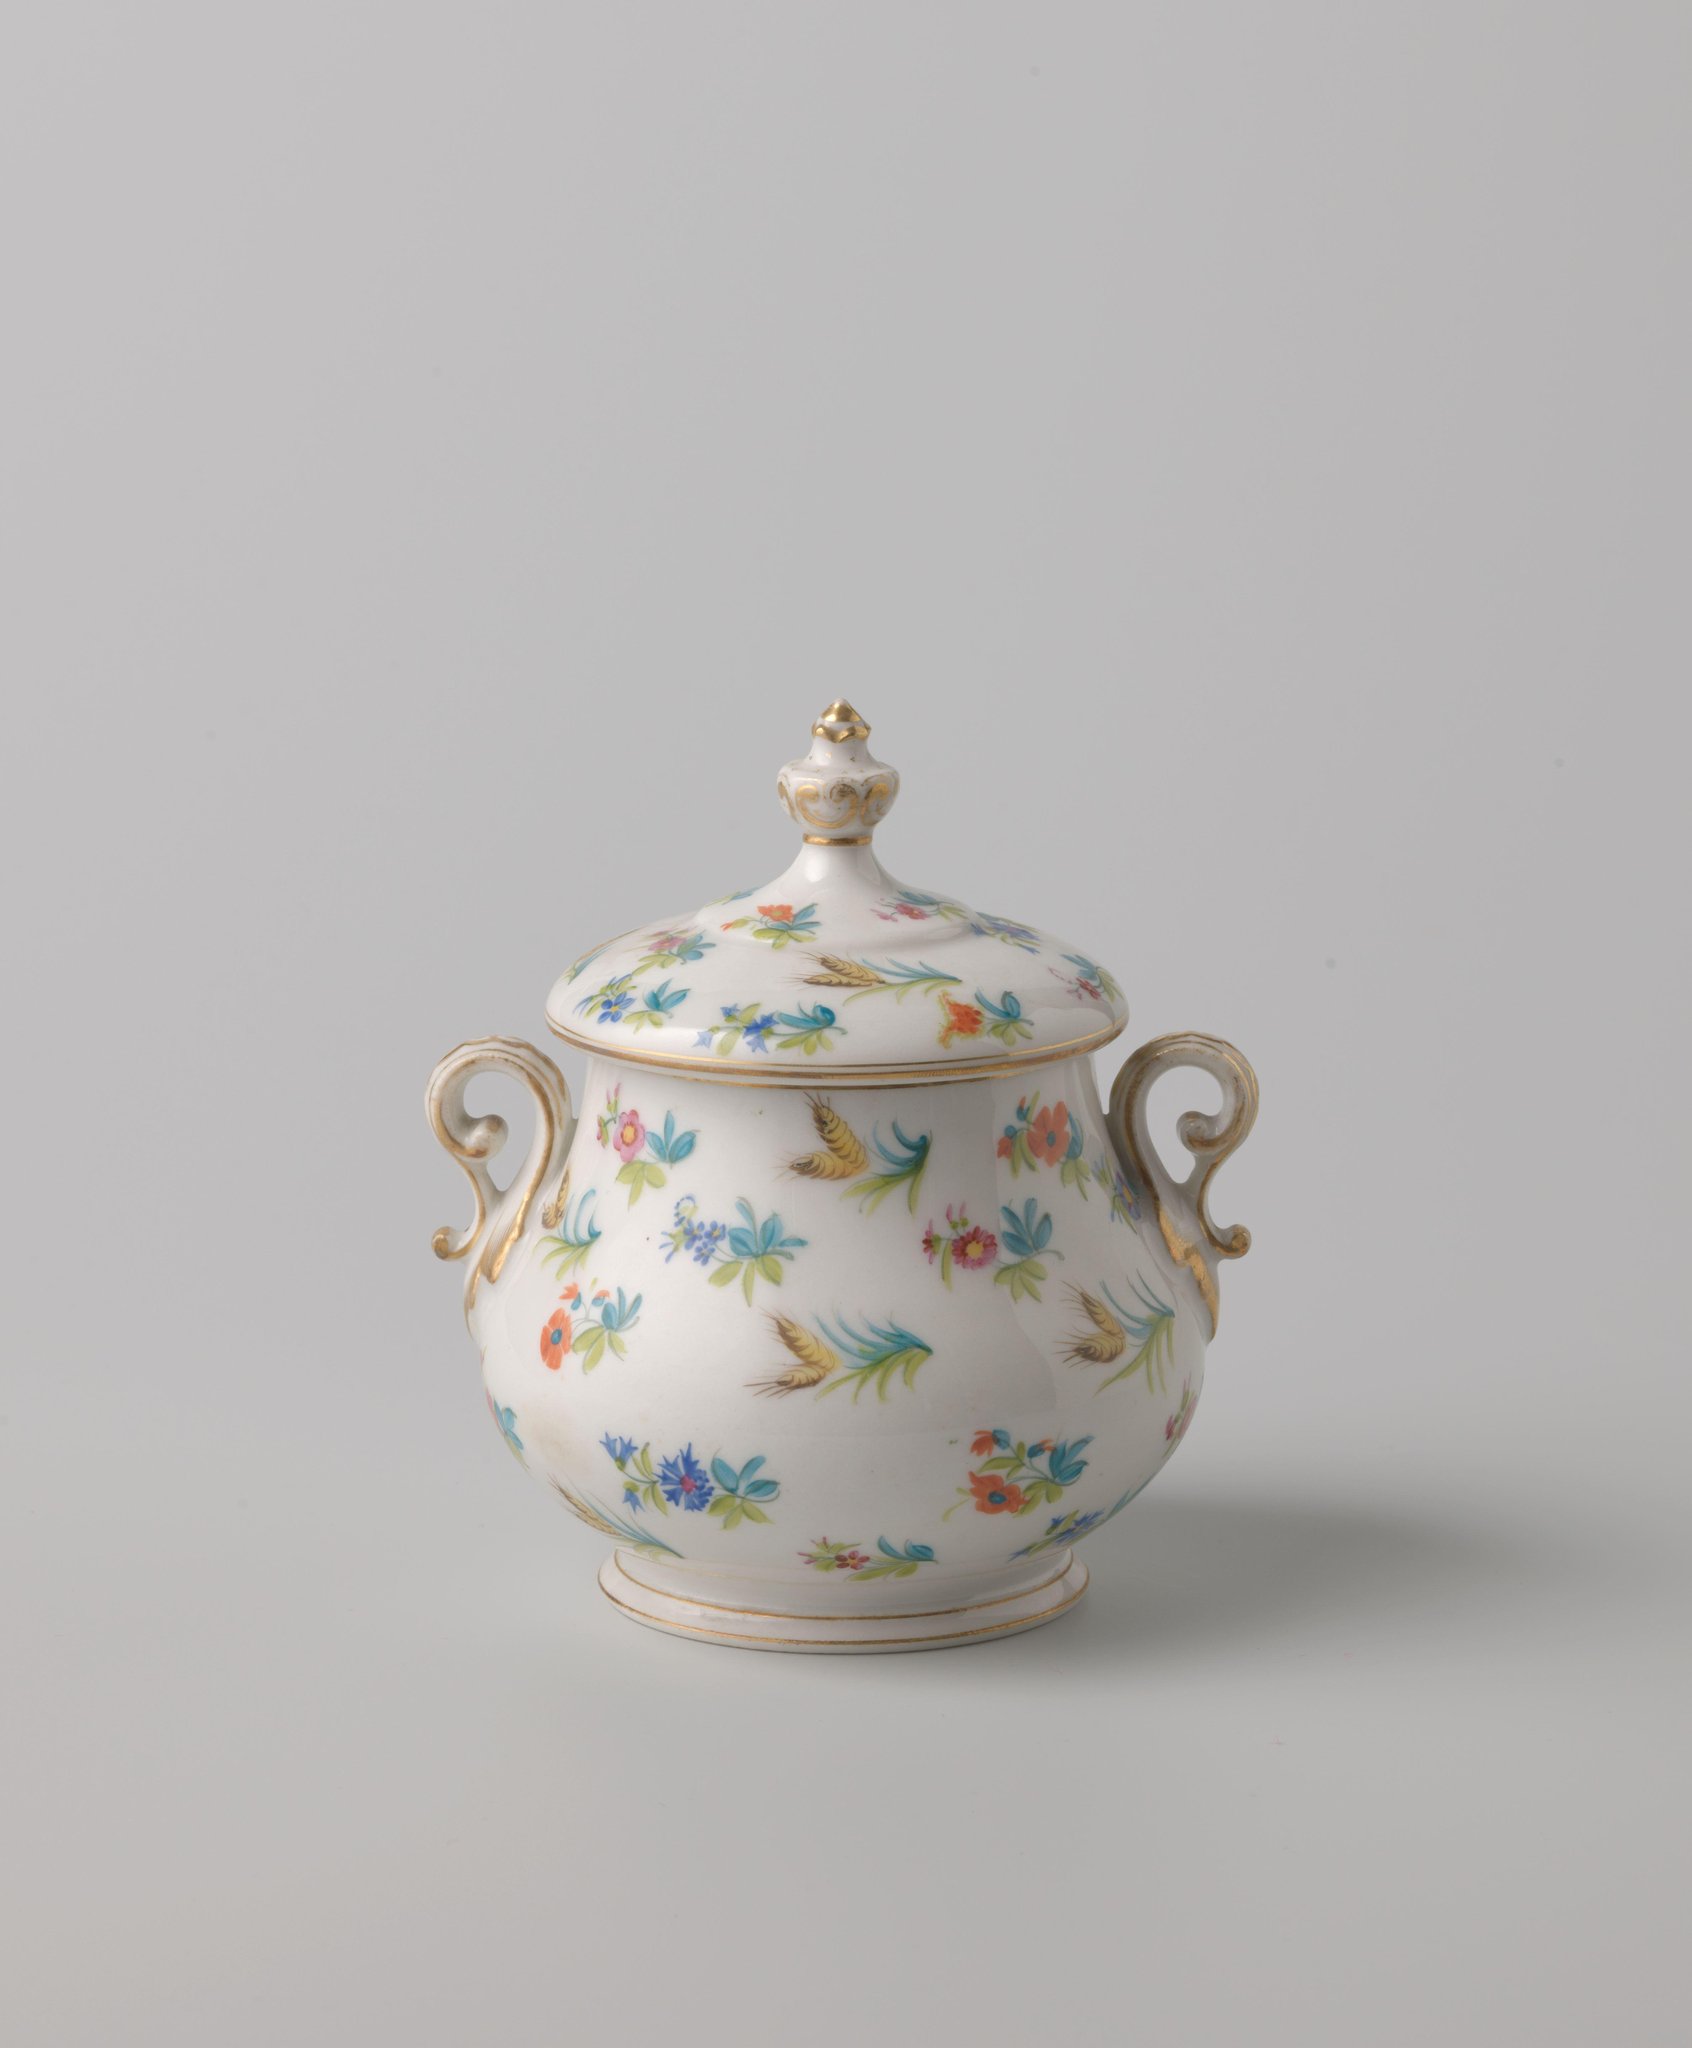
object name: service set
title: Sugar bowl with flower sprays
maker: Anonymous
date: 1860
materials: glaze, gold, paint, porcelain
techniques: firing, forming, gilding, turning, vitrification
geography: france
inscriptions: mark: ‘II/ 165’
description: Suikerpot van porselein met een gedrukt bolvormig lichaam, wijde nek en twee oren in een gekrulde bladvorm, beschilderd op het glazuur in blauw, rood, roze, groen, geel, bruin en goud. Op het lichaam bloemtakken en gouden lijnen op de rand en voet. De oren met een decoratieve band. Deksel met dezelfde decoratie en een halfronde, tienhoekige dekselknop uitlopend in een punt. Gemerkt op de onderzijde met II en 165.